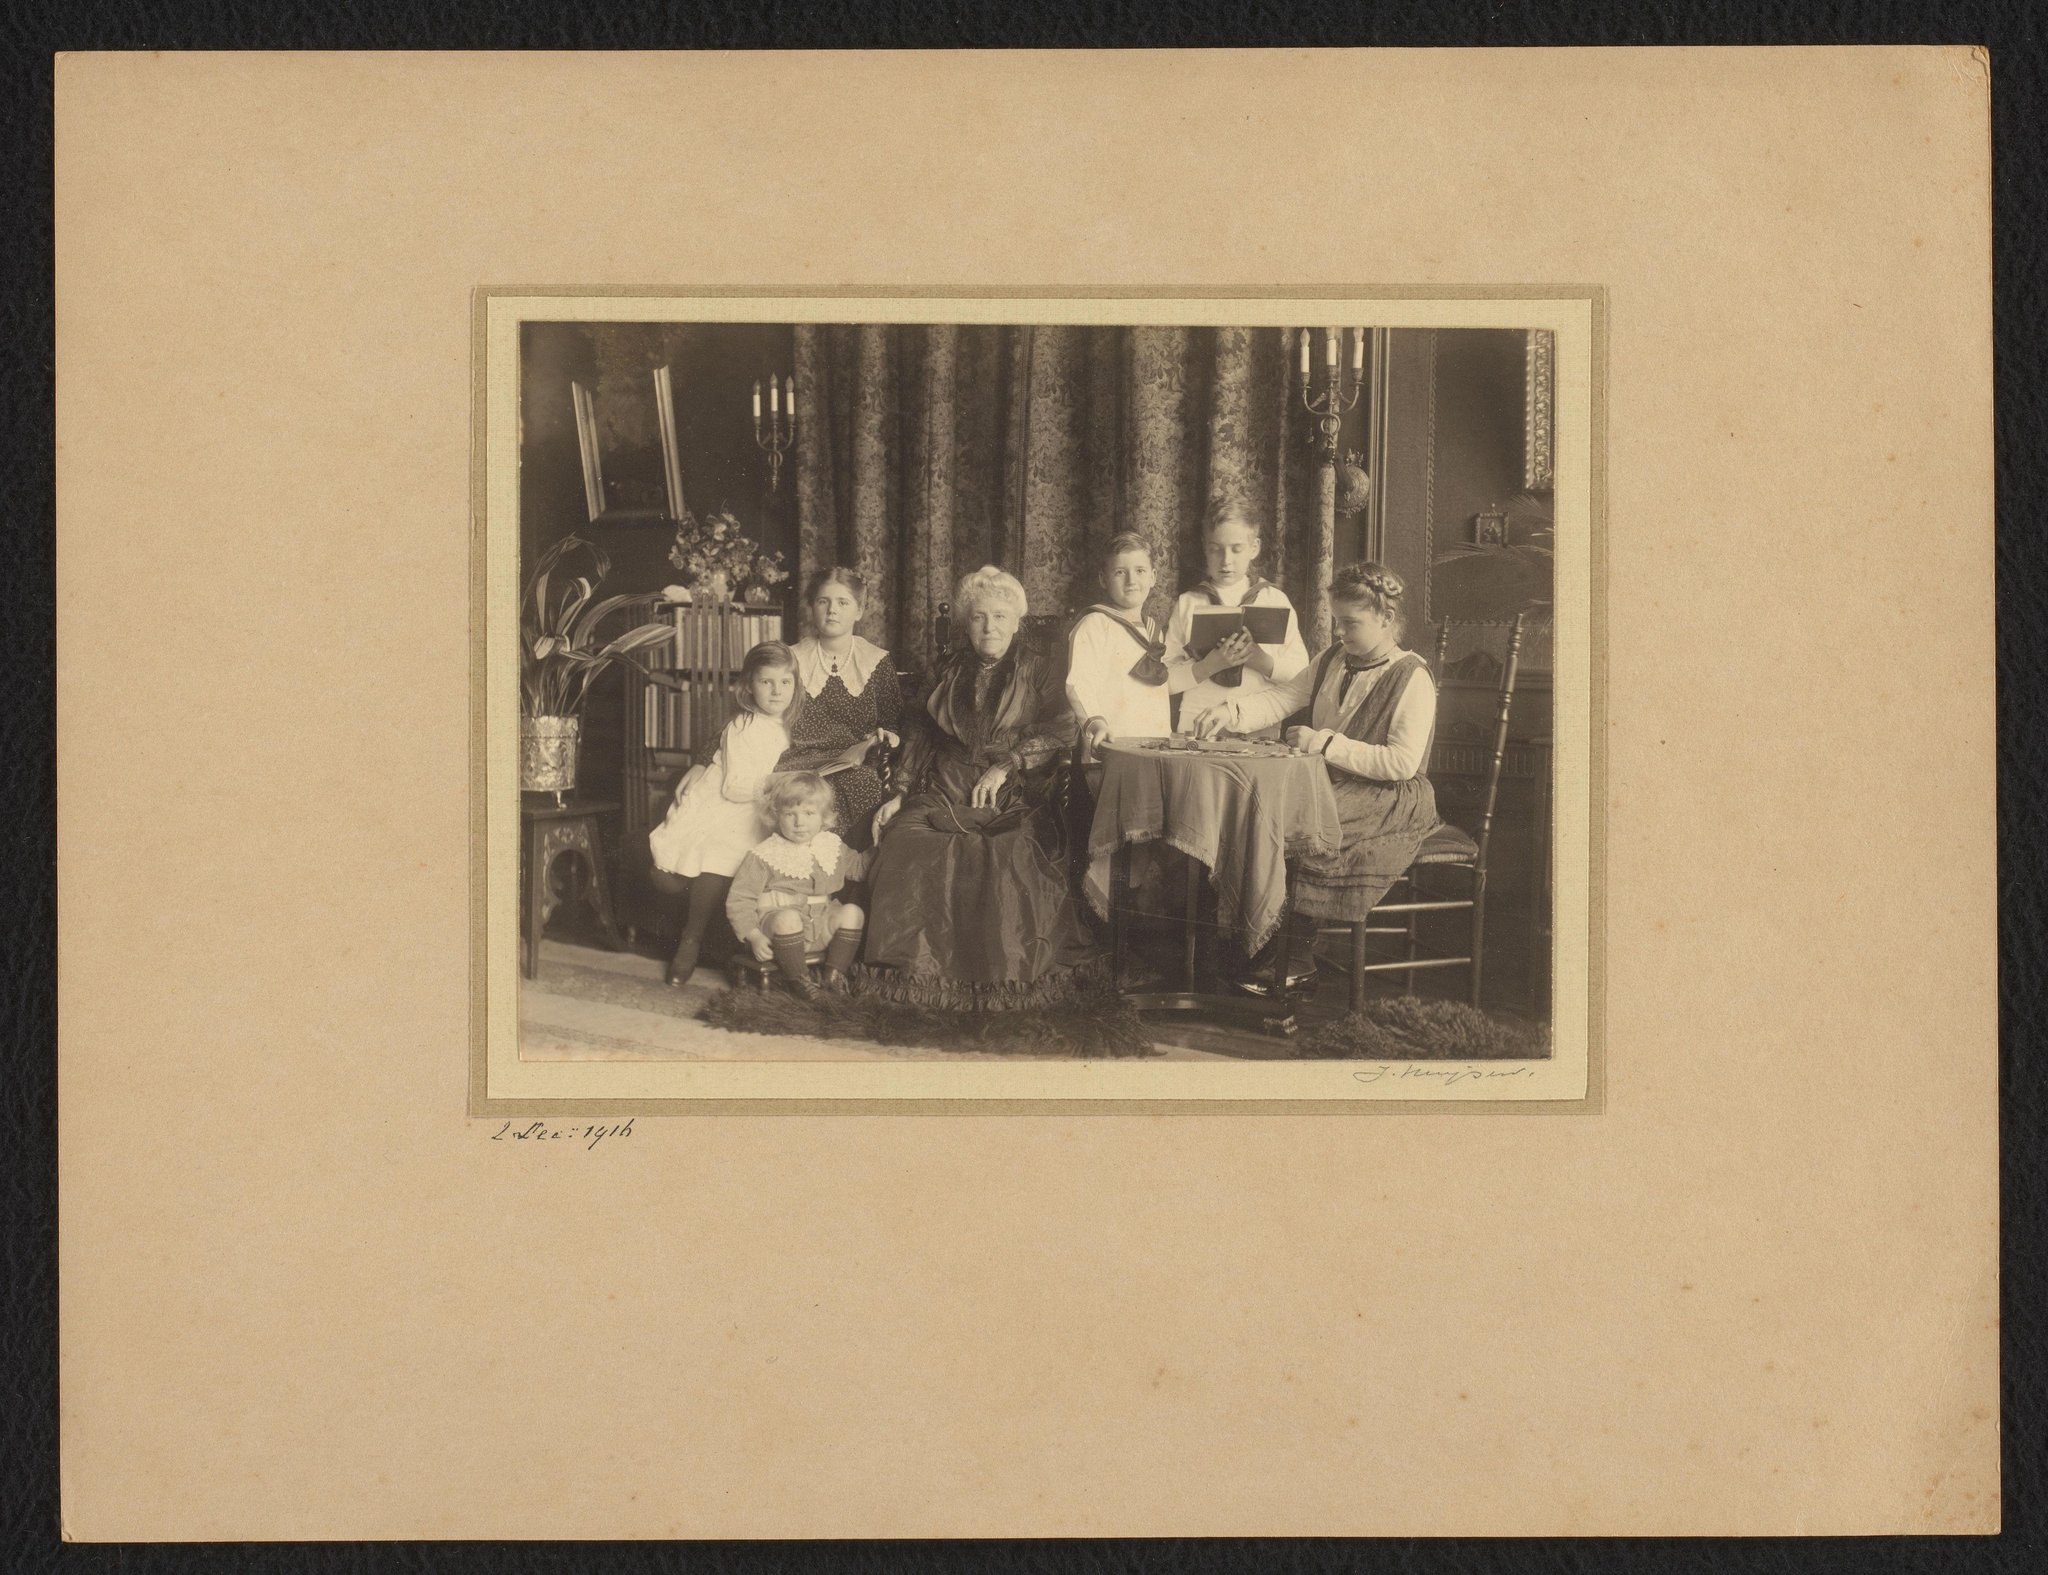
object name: photograph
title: Groepsportret van zes onbekende kinderen en een oude vrouw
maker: johannes maria petrus antonius huijsen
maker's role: fotograaf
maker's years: 1877-1959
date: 1916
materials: cardboard, paper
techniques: gelatin silver print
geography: amsterdam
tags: anonymous historical persons portrayed in a group, in a group-portrait